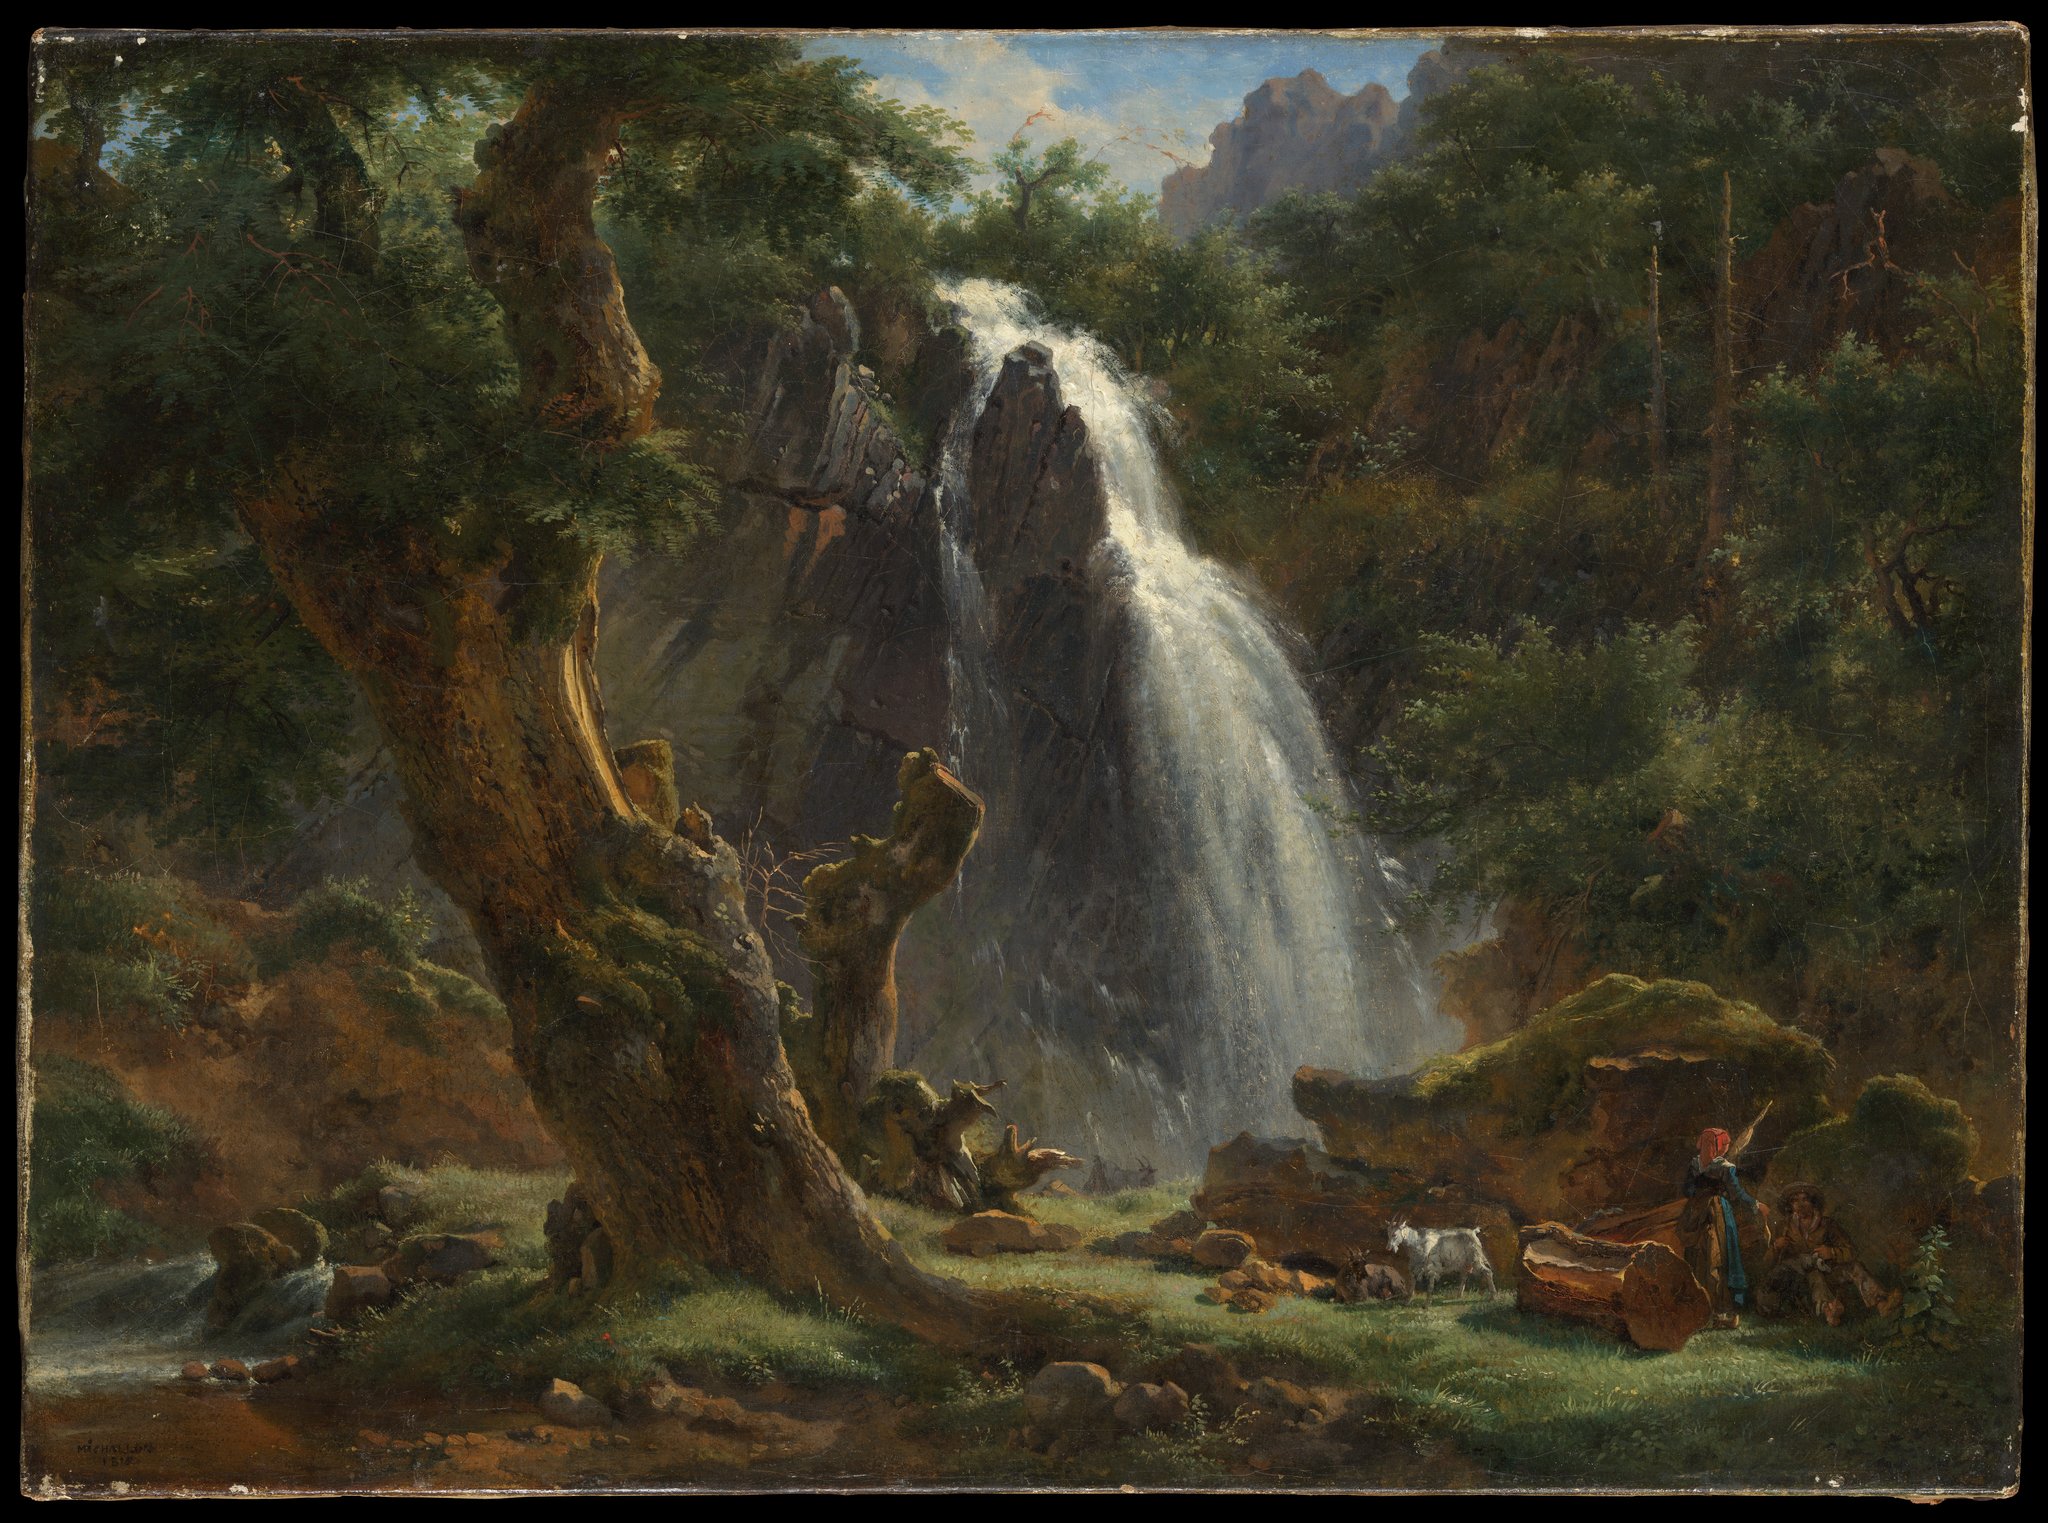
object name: painting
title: Waterfall at Mont-Dore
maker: achille-etna michallon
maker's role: artist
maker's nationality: french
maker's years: 1796-1822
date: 1818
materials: canvas, oil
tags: waterfalls